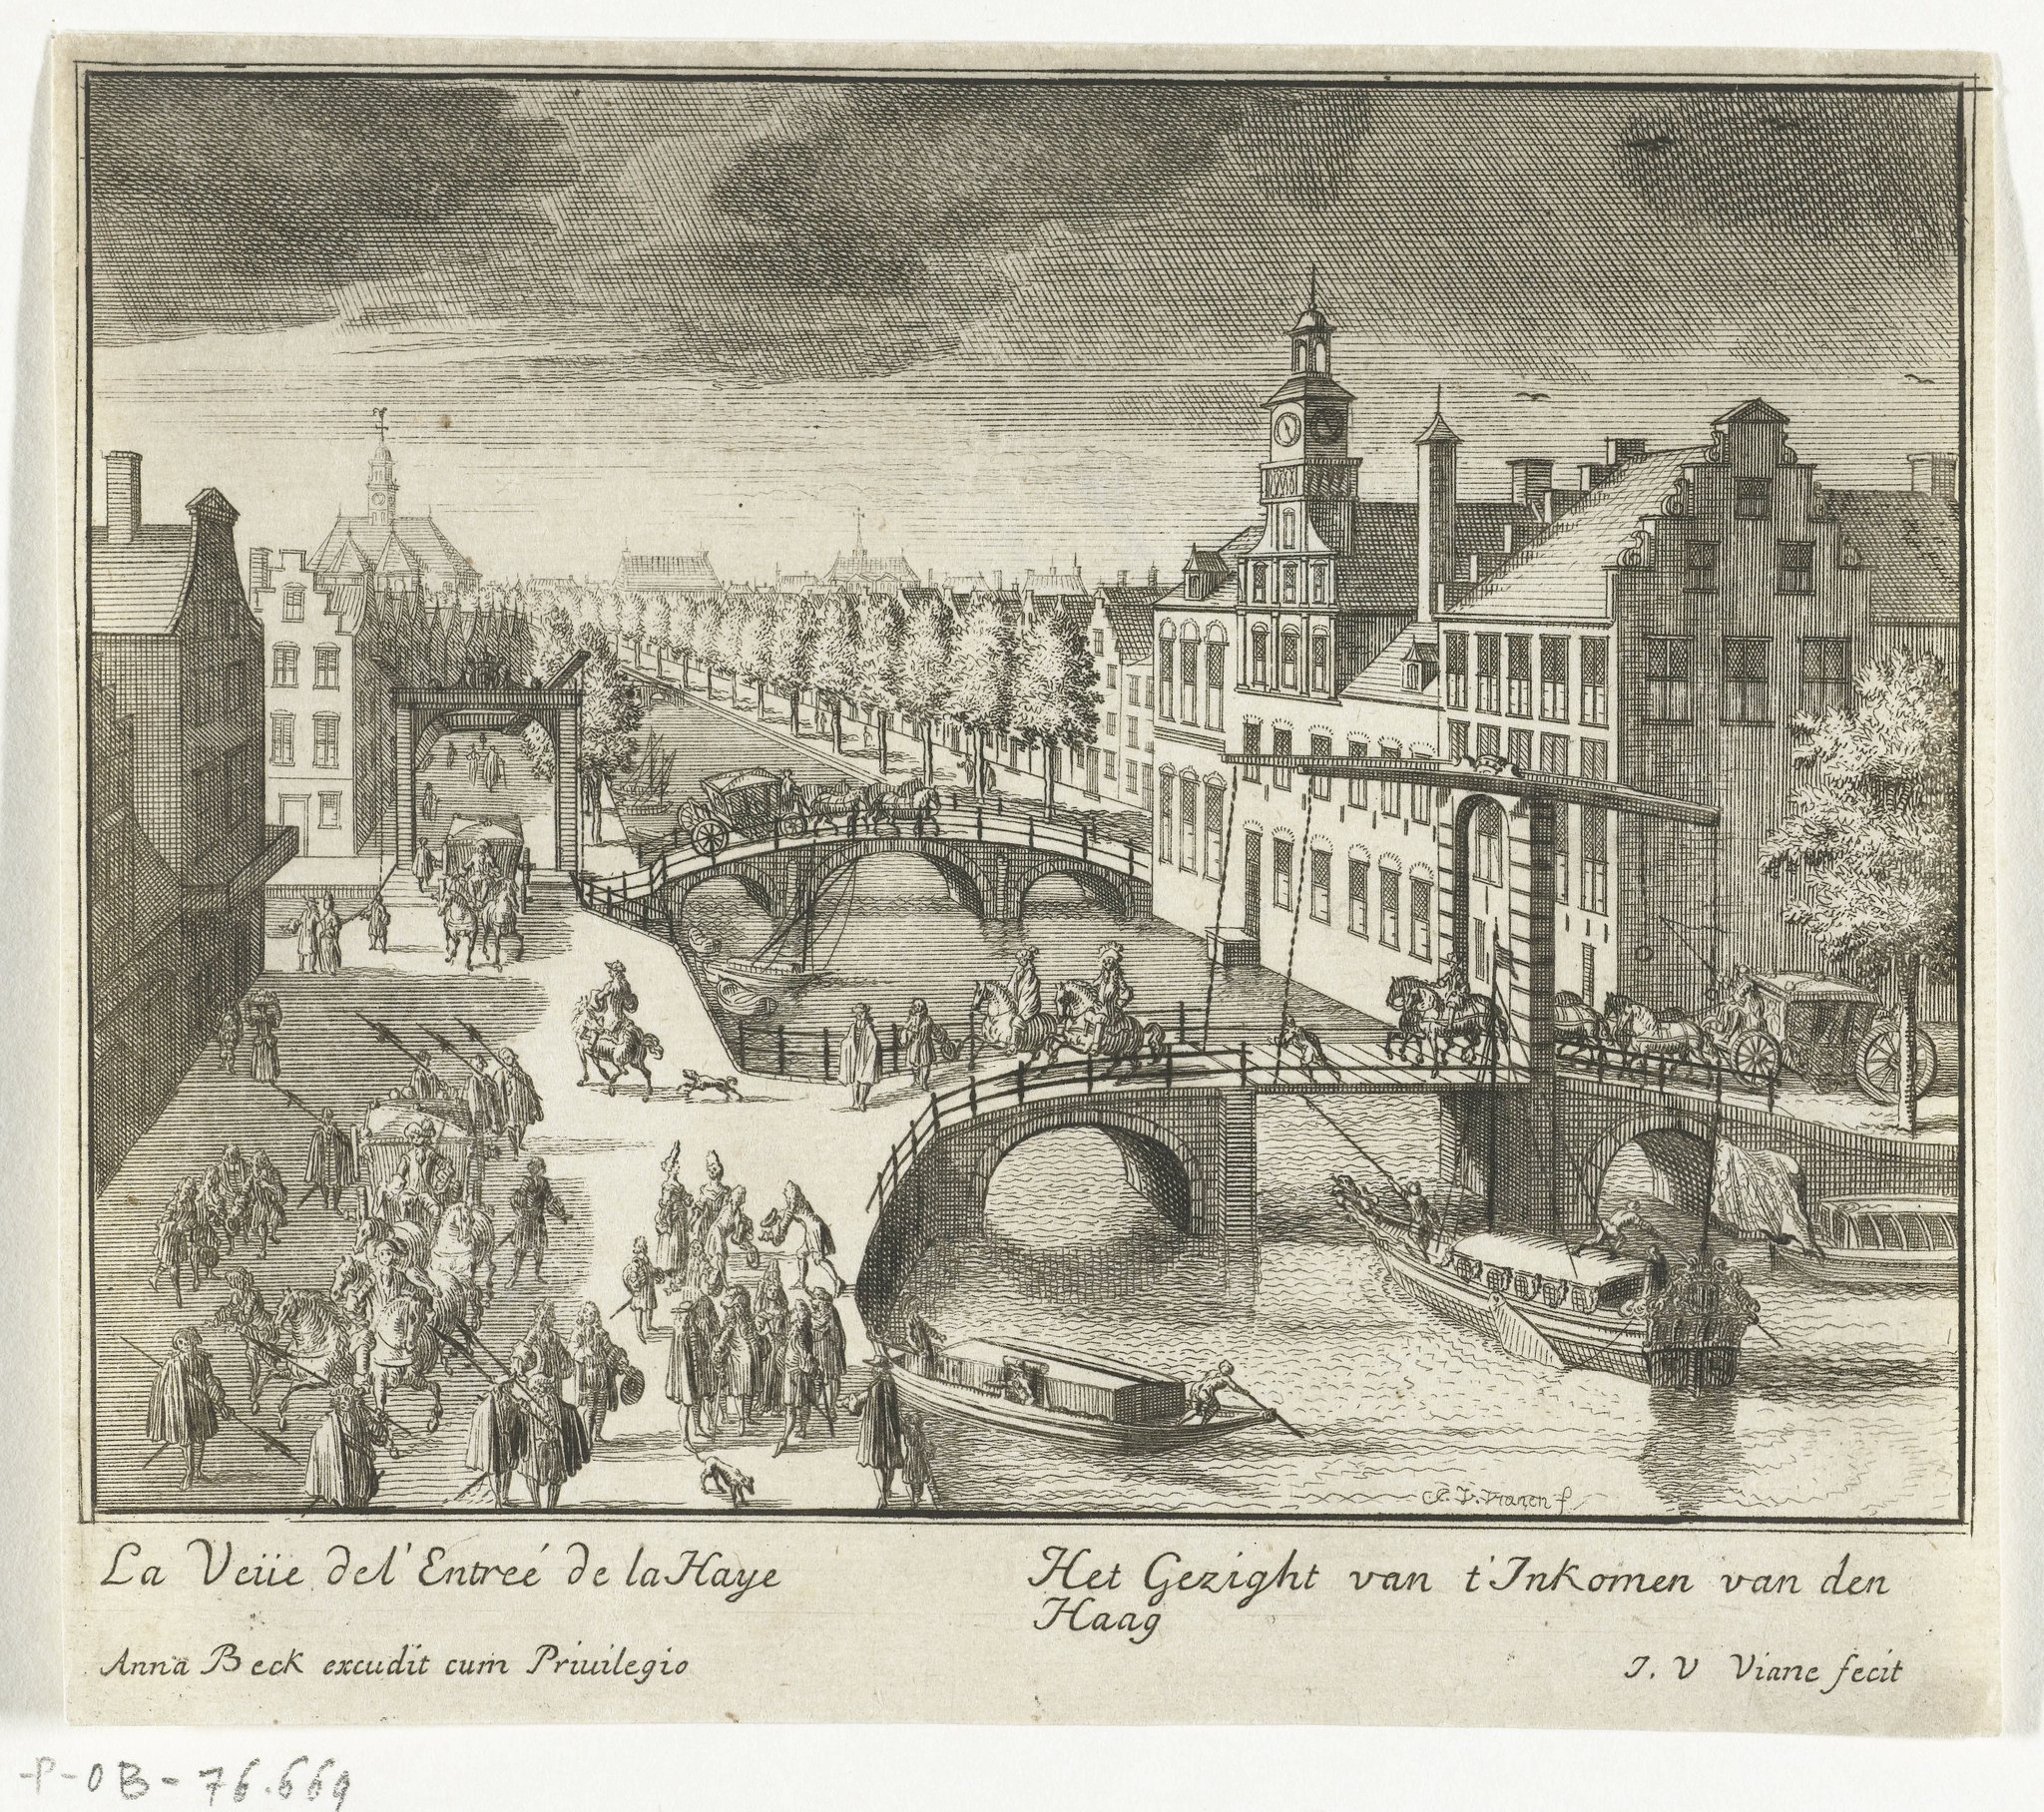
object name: print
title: Serie van zestien kleine prenten over het Huis ter Nieuburch in Rijswijk en de vredesonderhandelingen, 1697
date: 1697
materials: paper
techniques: etching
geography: the hague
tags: the hague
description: Gezicht bij het binnenkomen van Den Haag. In het onderschrift de twee titels in het Frans en Nederlands. Onderdeel (prent 13) van de serie van zestien kleinere prenten over het Huis ter Nieuburch in Rijswijk en de daar gehouden vredesonderhandelingen resulterend in de Vrede van Rijswijk gesloten op 20 september 1697.